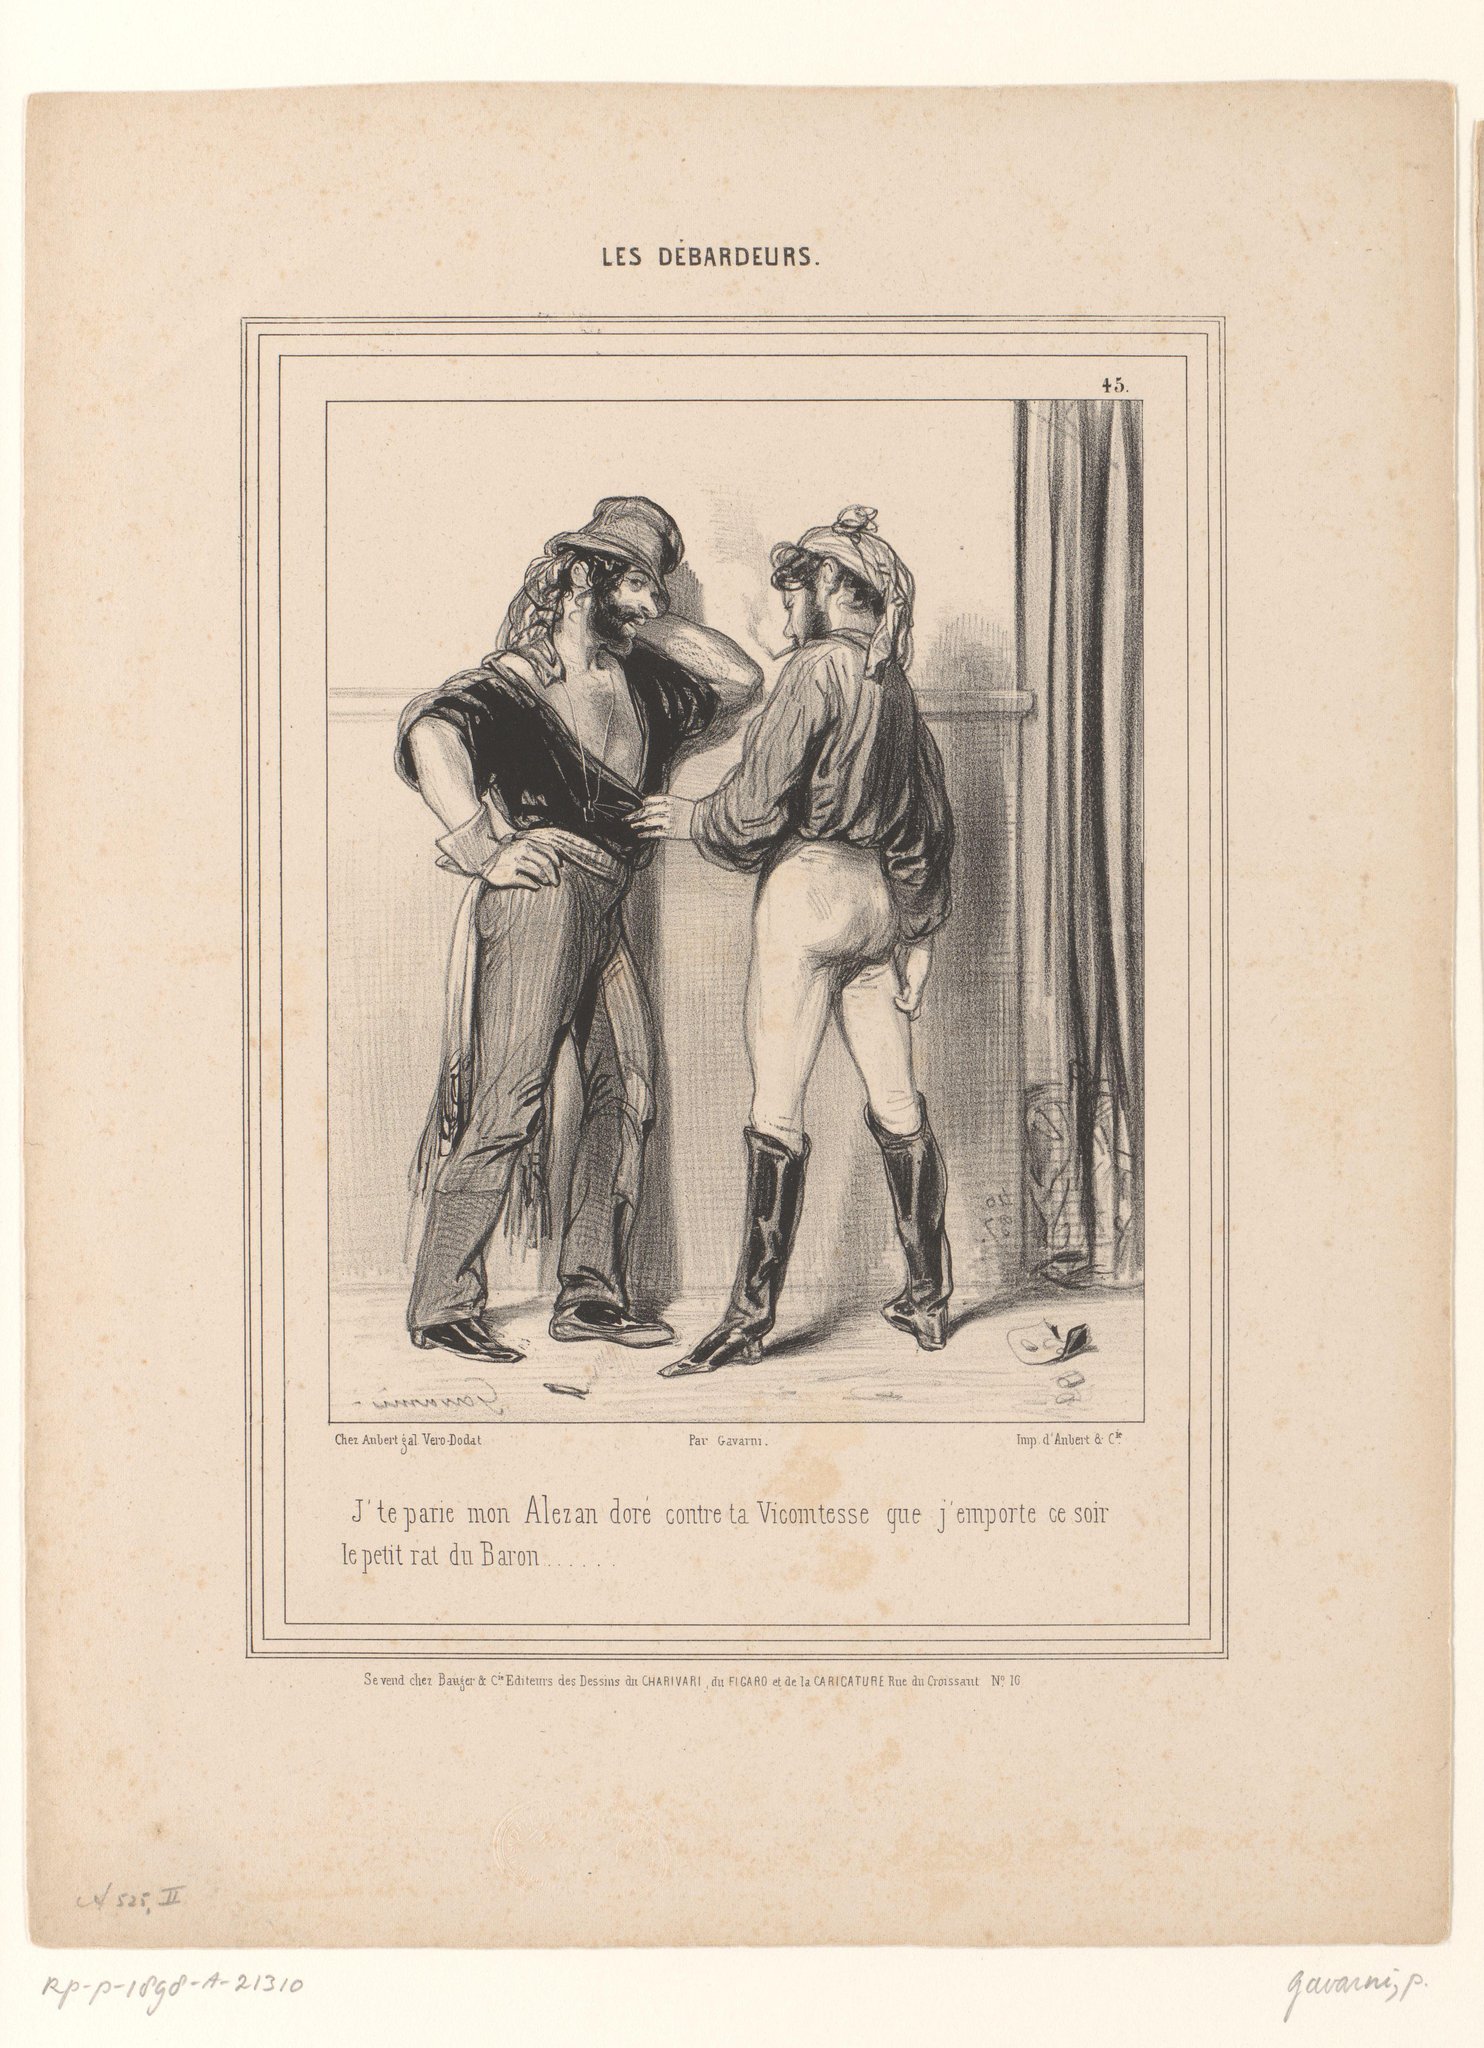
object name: cartoon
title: Modieuze kostuums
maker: paul gavarni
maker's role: draughtsman, print maker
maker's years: 1804-1866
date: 1841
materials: paper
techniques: lithograph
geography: paris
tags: riding a horse, ass, or mule; rider, horseman, fashion, clothing, betting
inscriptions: collector's mark: Lugt 964, check stamp: Lugt 3855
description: Prent gebruikt voor: Le Charivari, 10 februari 1841.